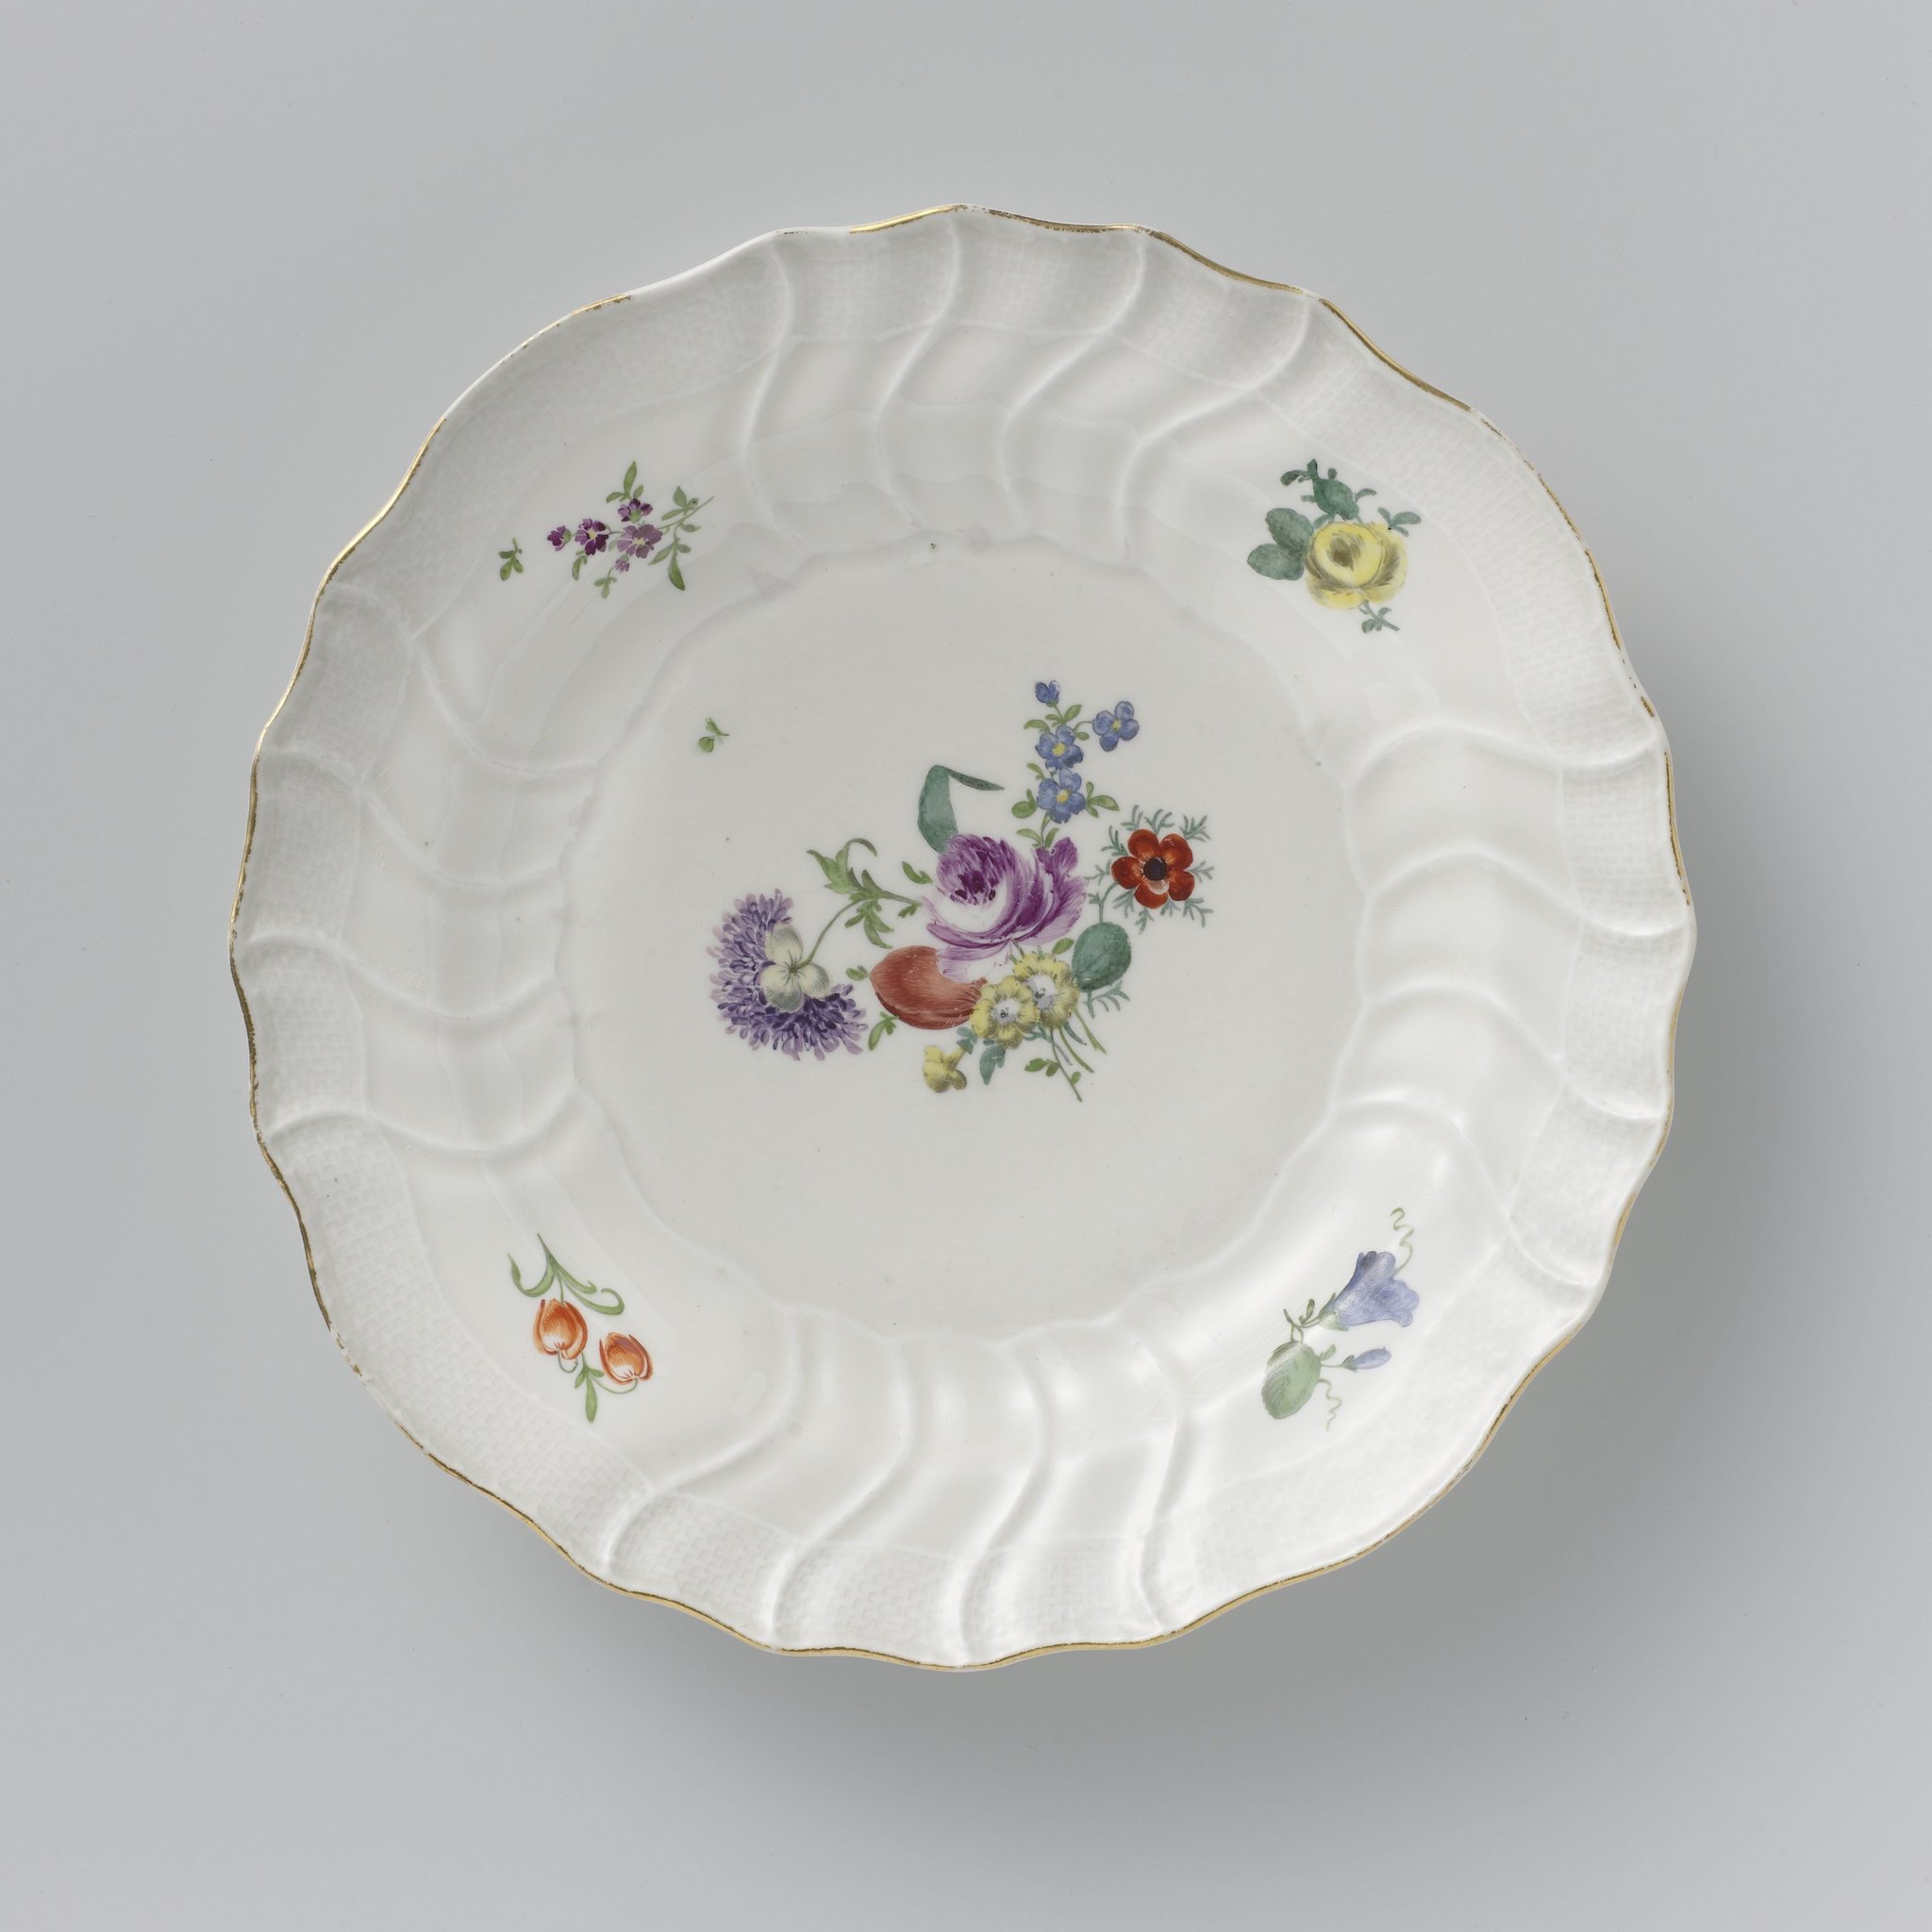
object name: plate dish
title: Bord, veelkleurig beschilderd met Deutsche Blumen, insekten en vruchten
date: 1750-1760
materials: porcelain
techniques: painted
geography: meissen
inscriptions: factory mark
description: Rond bord van beschilderd porselein. Het bord is beschilderd met Deutsche Blumen, insekten en vruchten. De rand is in reliëf versierd met het Neuozier-patroon. Het bord is gemerkt en hoort bij een servies (BK-17474-1 t/m BK-17474-253).